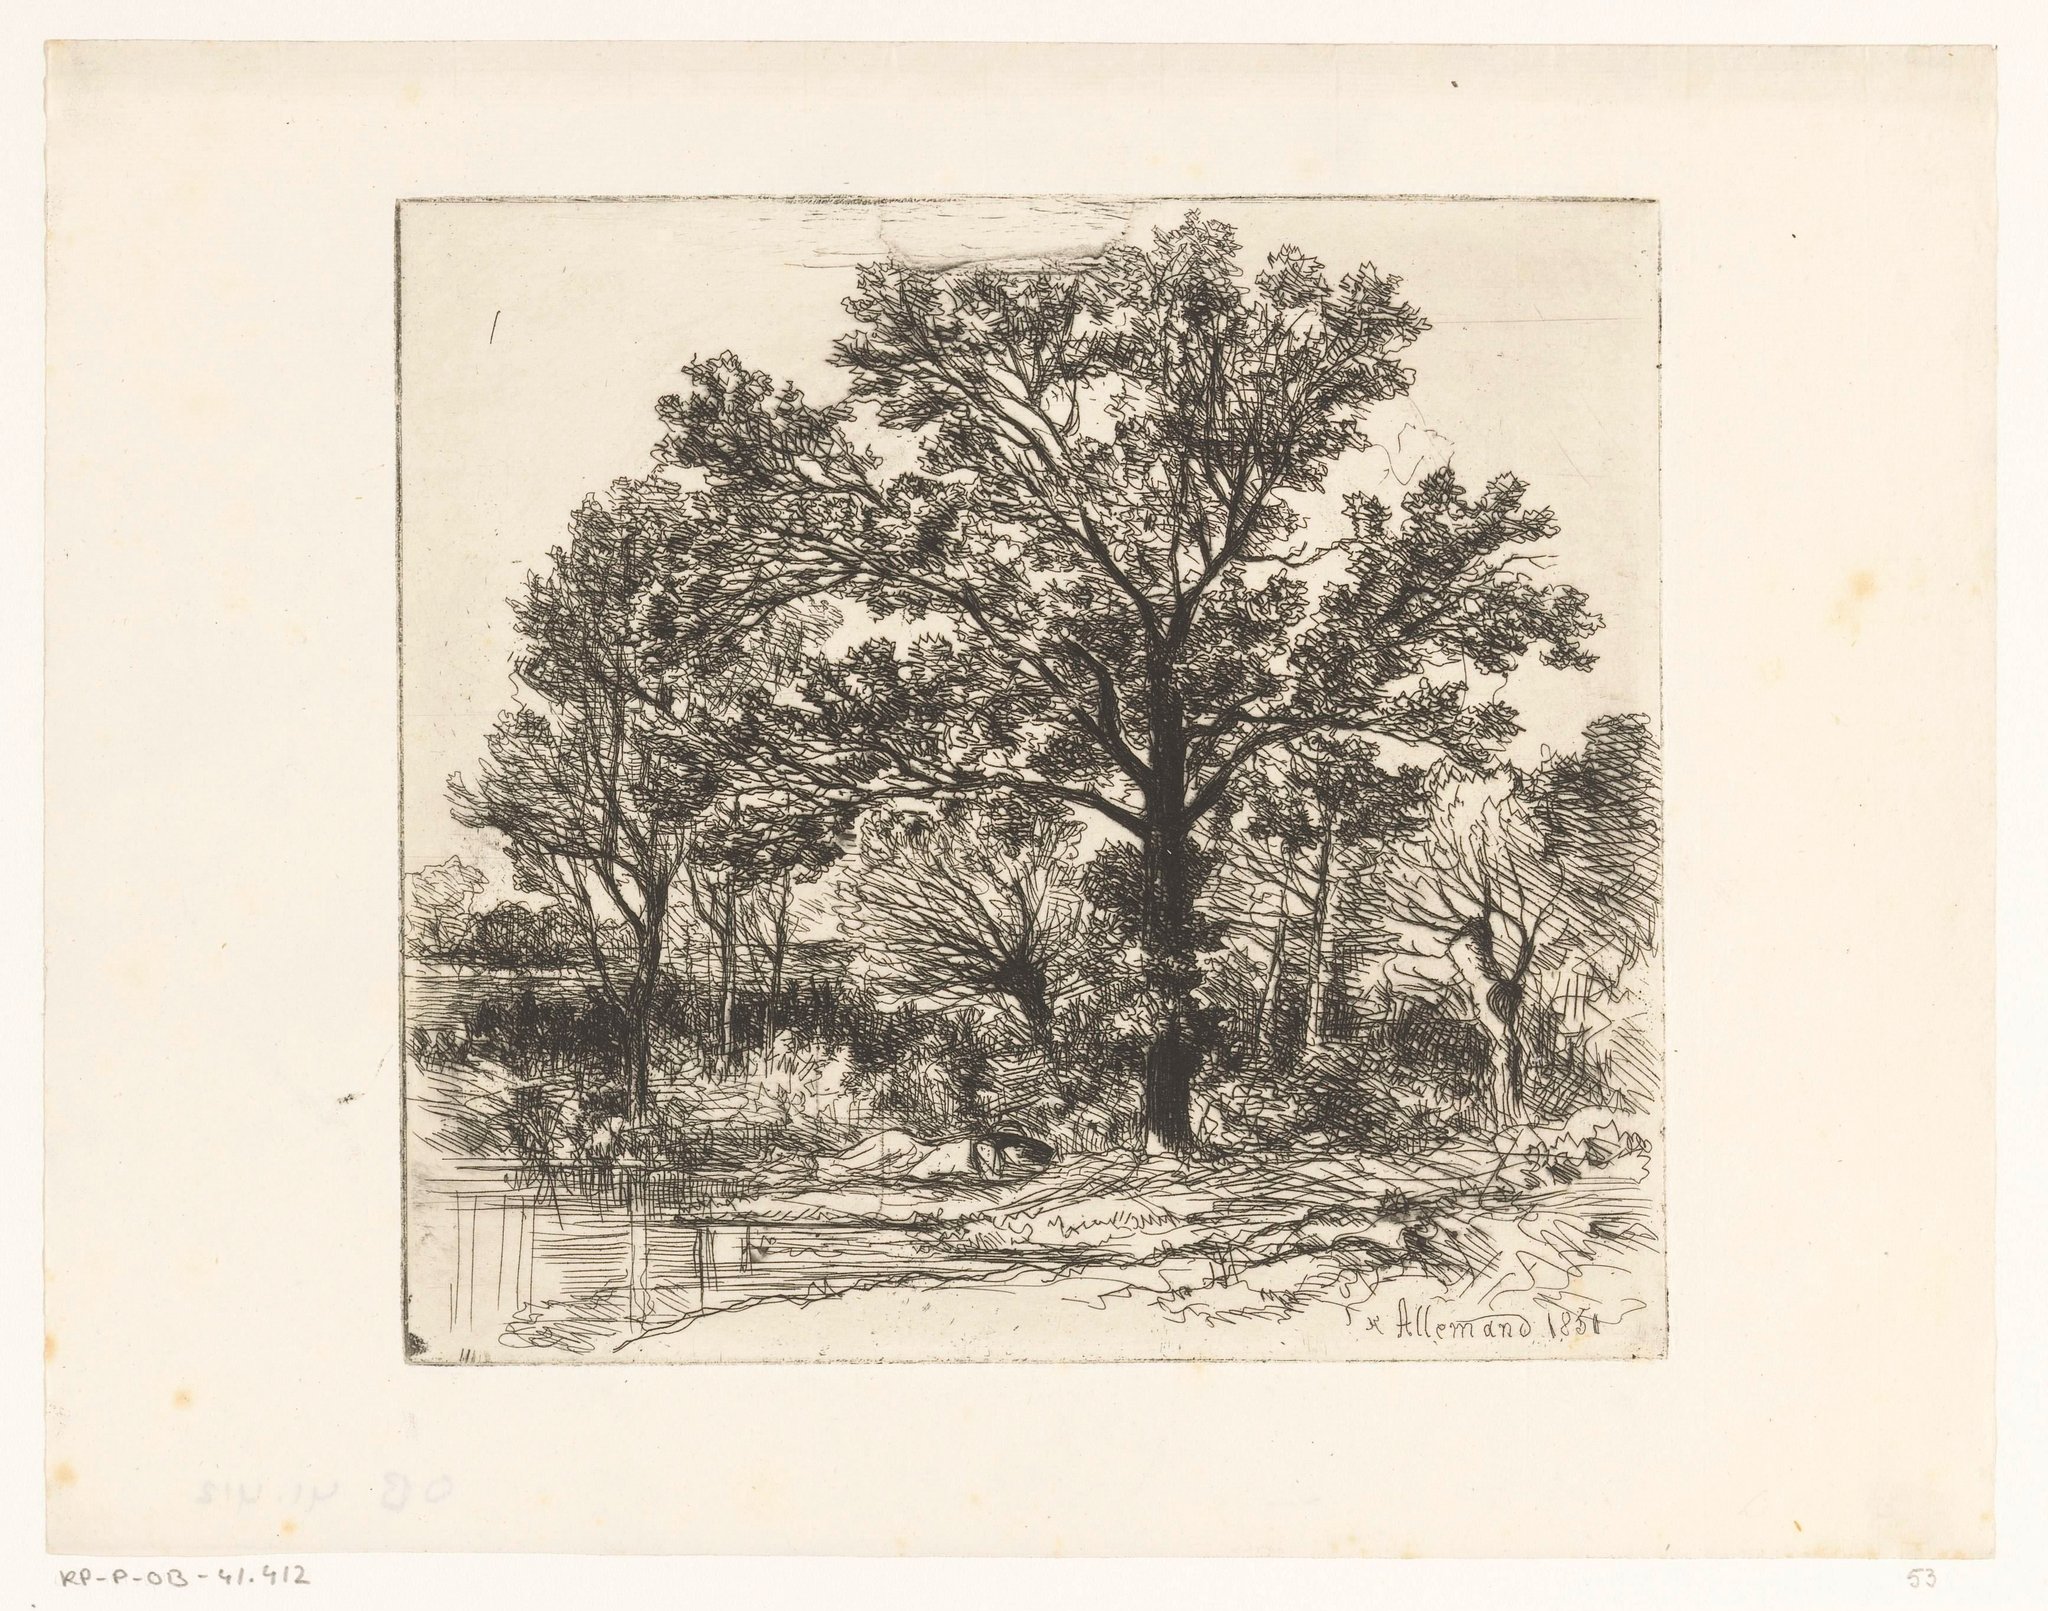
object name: print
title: Bomen aan de waterkant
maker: hector allemand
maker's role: print maker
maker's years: 1809-1886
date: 1851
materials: paper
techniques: drypoint, etching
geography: france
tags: trees, landscapes with waters, waterscapes, seascapes (in the temperate zone)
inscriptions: collector's mark: Lugt 2228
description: In de literatuur wordt naar deze prent verwezen als "Étude d'Arbres au bord d'une mare".